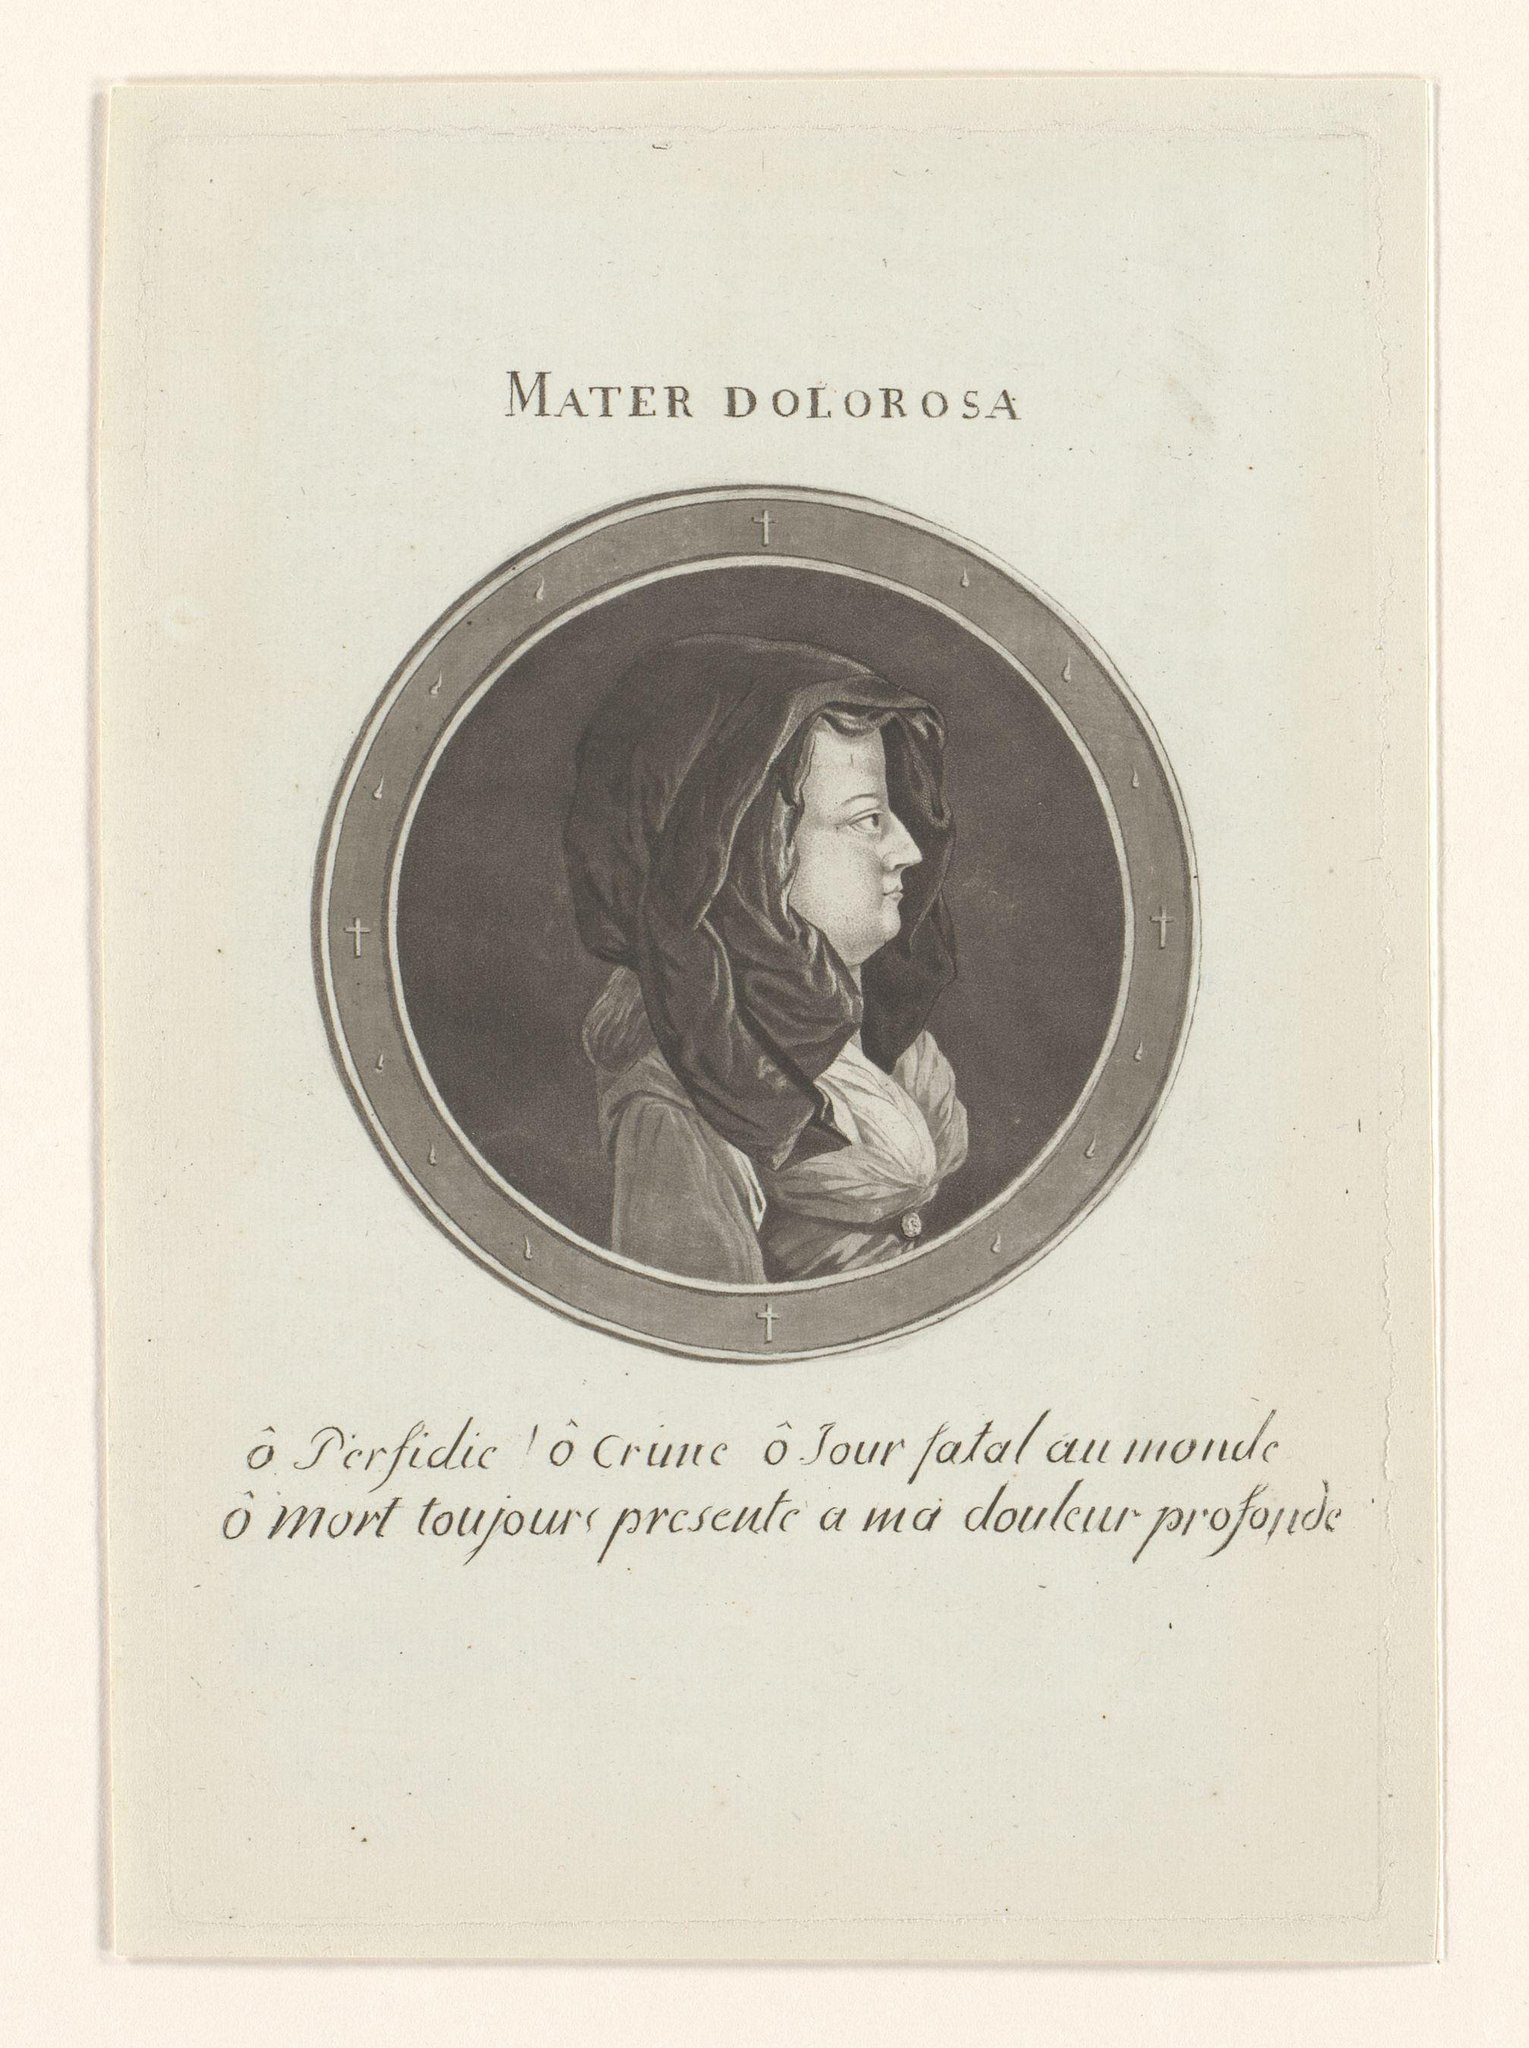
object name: print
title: Portret van Marie Antoinette als Mater Dolorosa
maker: Anonymous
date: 1793-1795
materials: paper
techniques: aquatint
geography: france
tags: vienna, paris, marie antoinette, historical persons - bb - woman, 'mater dolorosa'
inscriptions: collector's mark: Lugt 2233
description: Met tweeregelig onderschrift in het Frans uit Voltaire's Mérope.